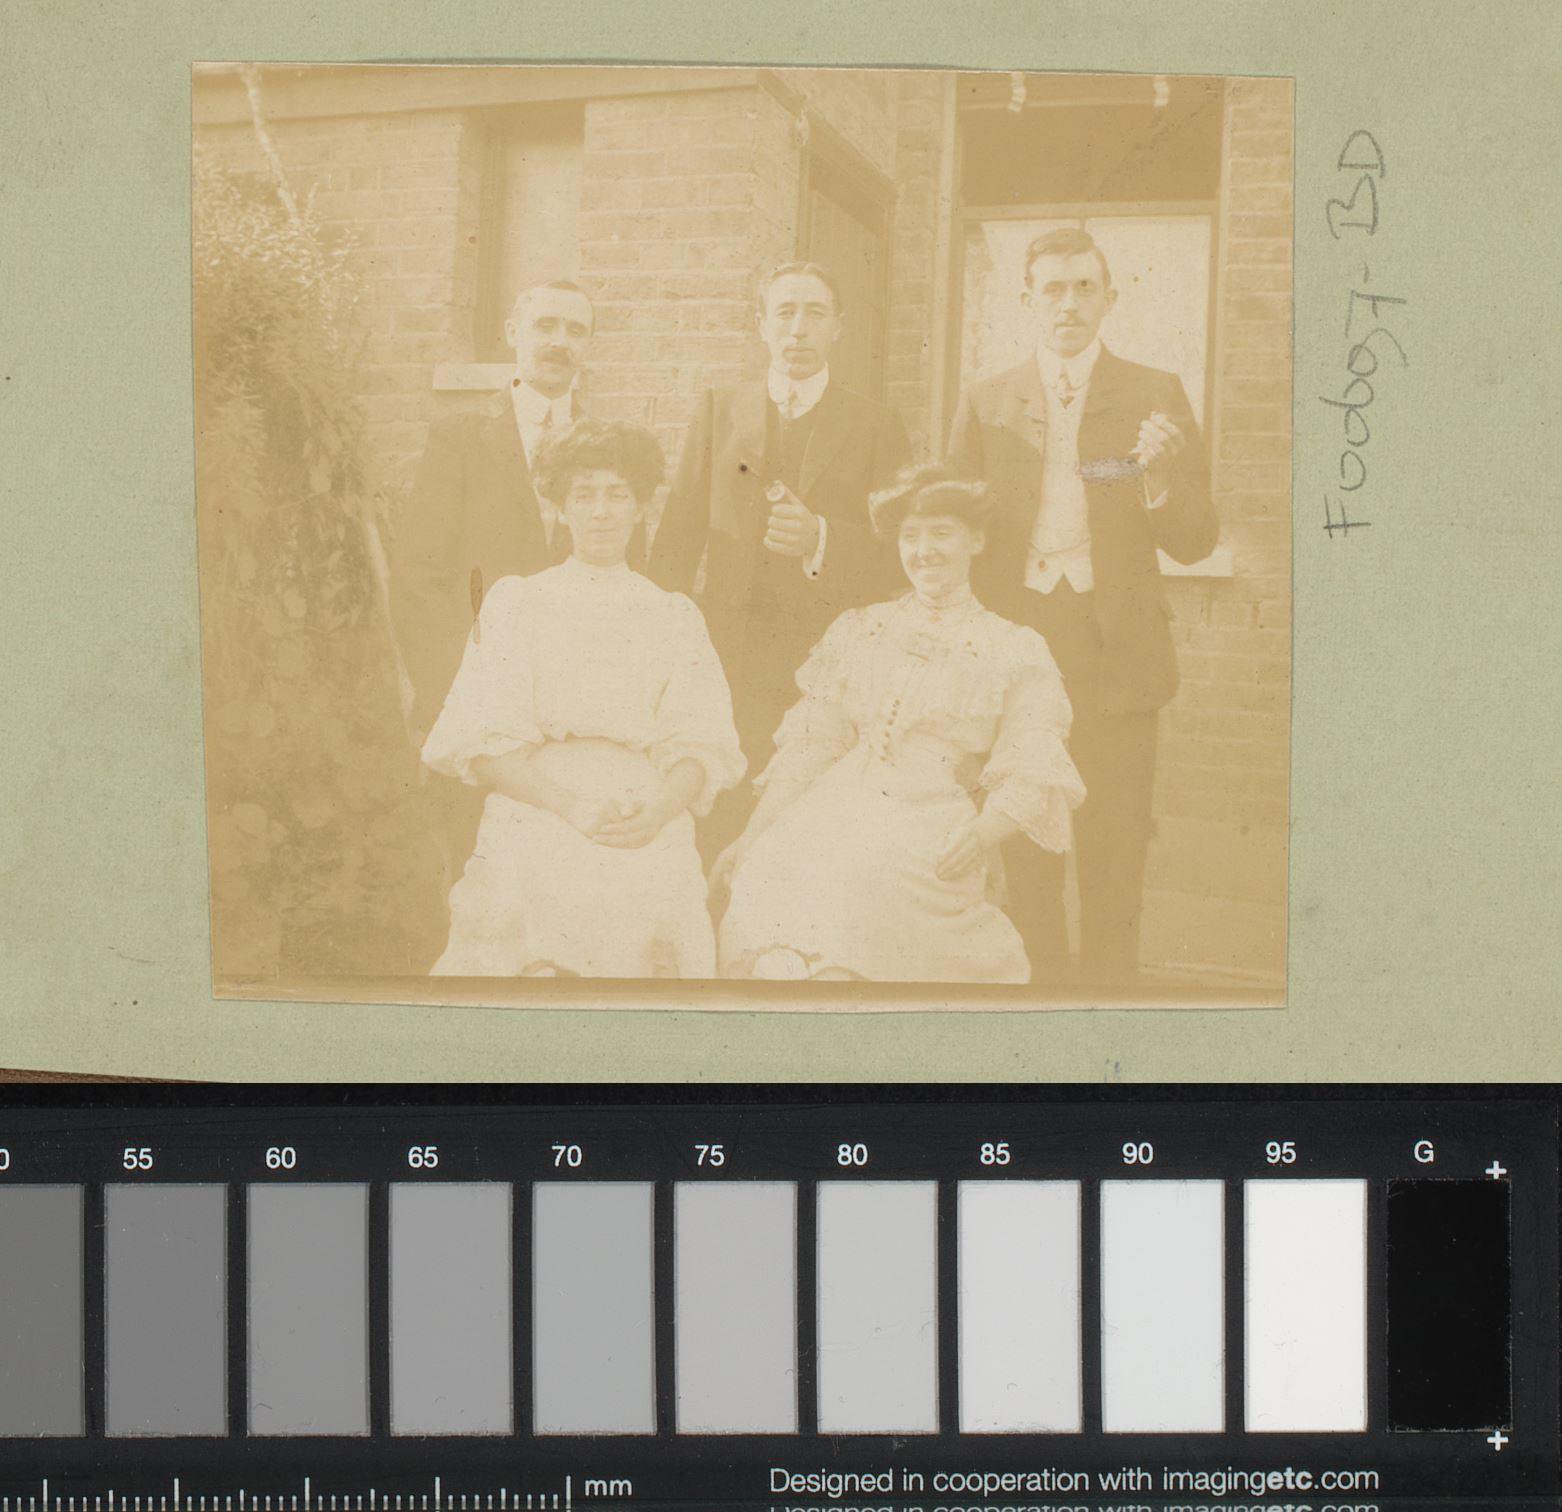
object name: album leaf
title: Groepsportret van mannen en vrouwen voor een huis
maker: Anonymous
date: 1890-1910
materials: photographic support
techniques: gelatin silver print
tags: adult woman, adult man, civic architecture; edifices; dwellings, anonymous historical persons portrayed in a group, in a group-portrait